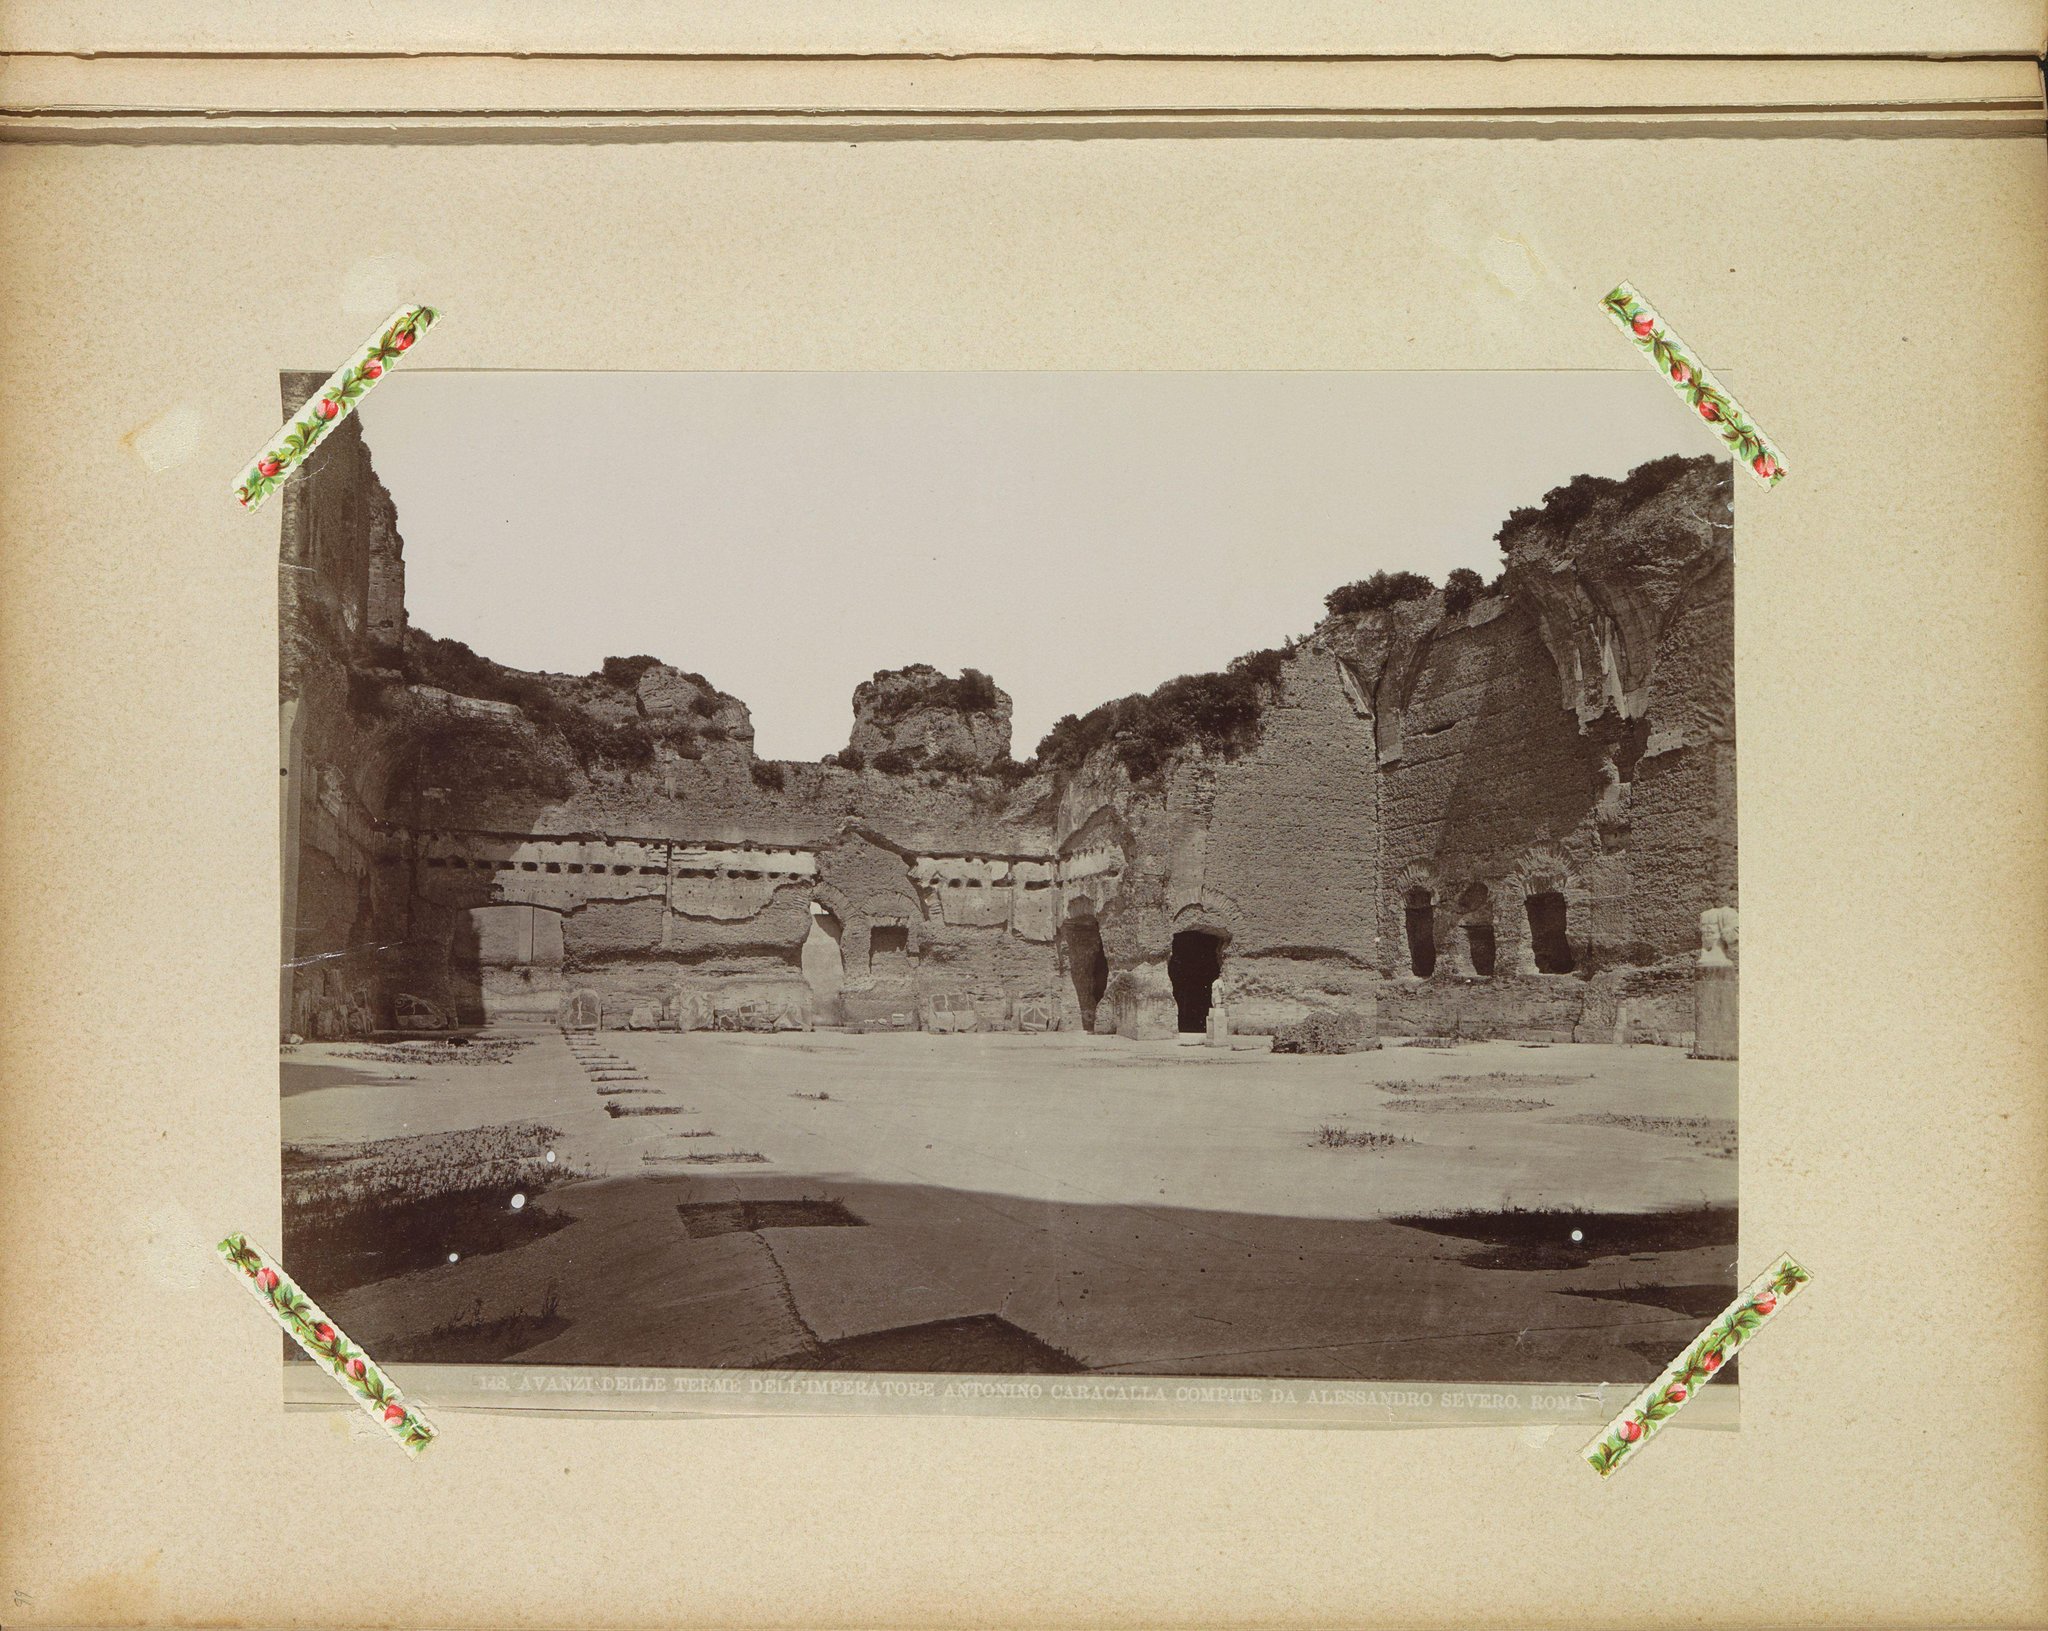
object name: photograph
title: Avanzi delle Terme dell'Imperatore Antonino Caracalla compite da Allessandro Severo. Roma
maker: Anonymous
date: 1860-1900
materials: photographic support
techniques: albumen print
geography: rome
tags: public baths, ruin of a dwelling, house, castle, etc.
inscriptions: number: ‘148’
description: Onderdeel van Fotoalbum met opnames van bezienswaardigheden in Italiaanse steden en van kunstwerken.